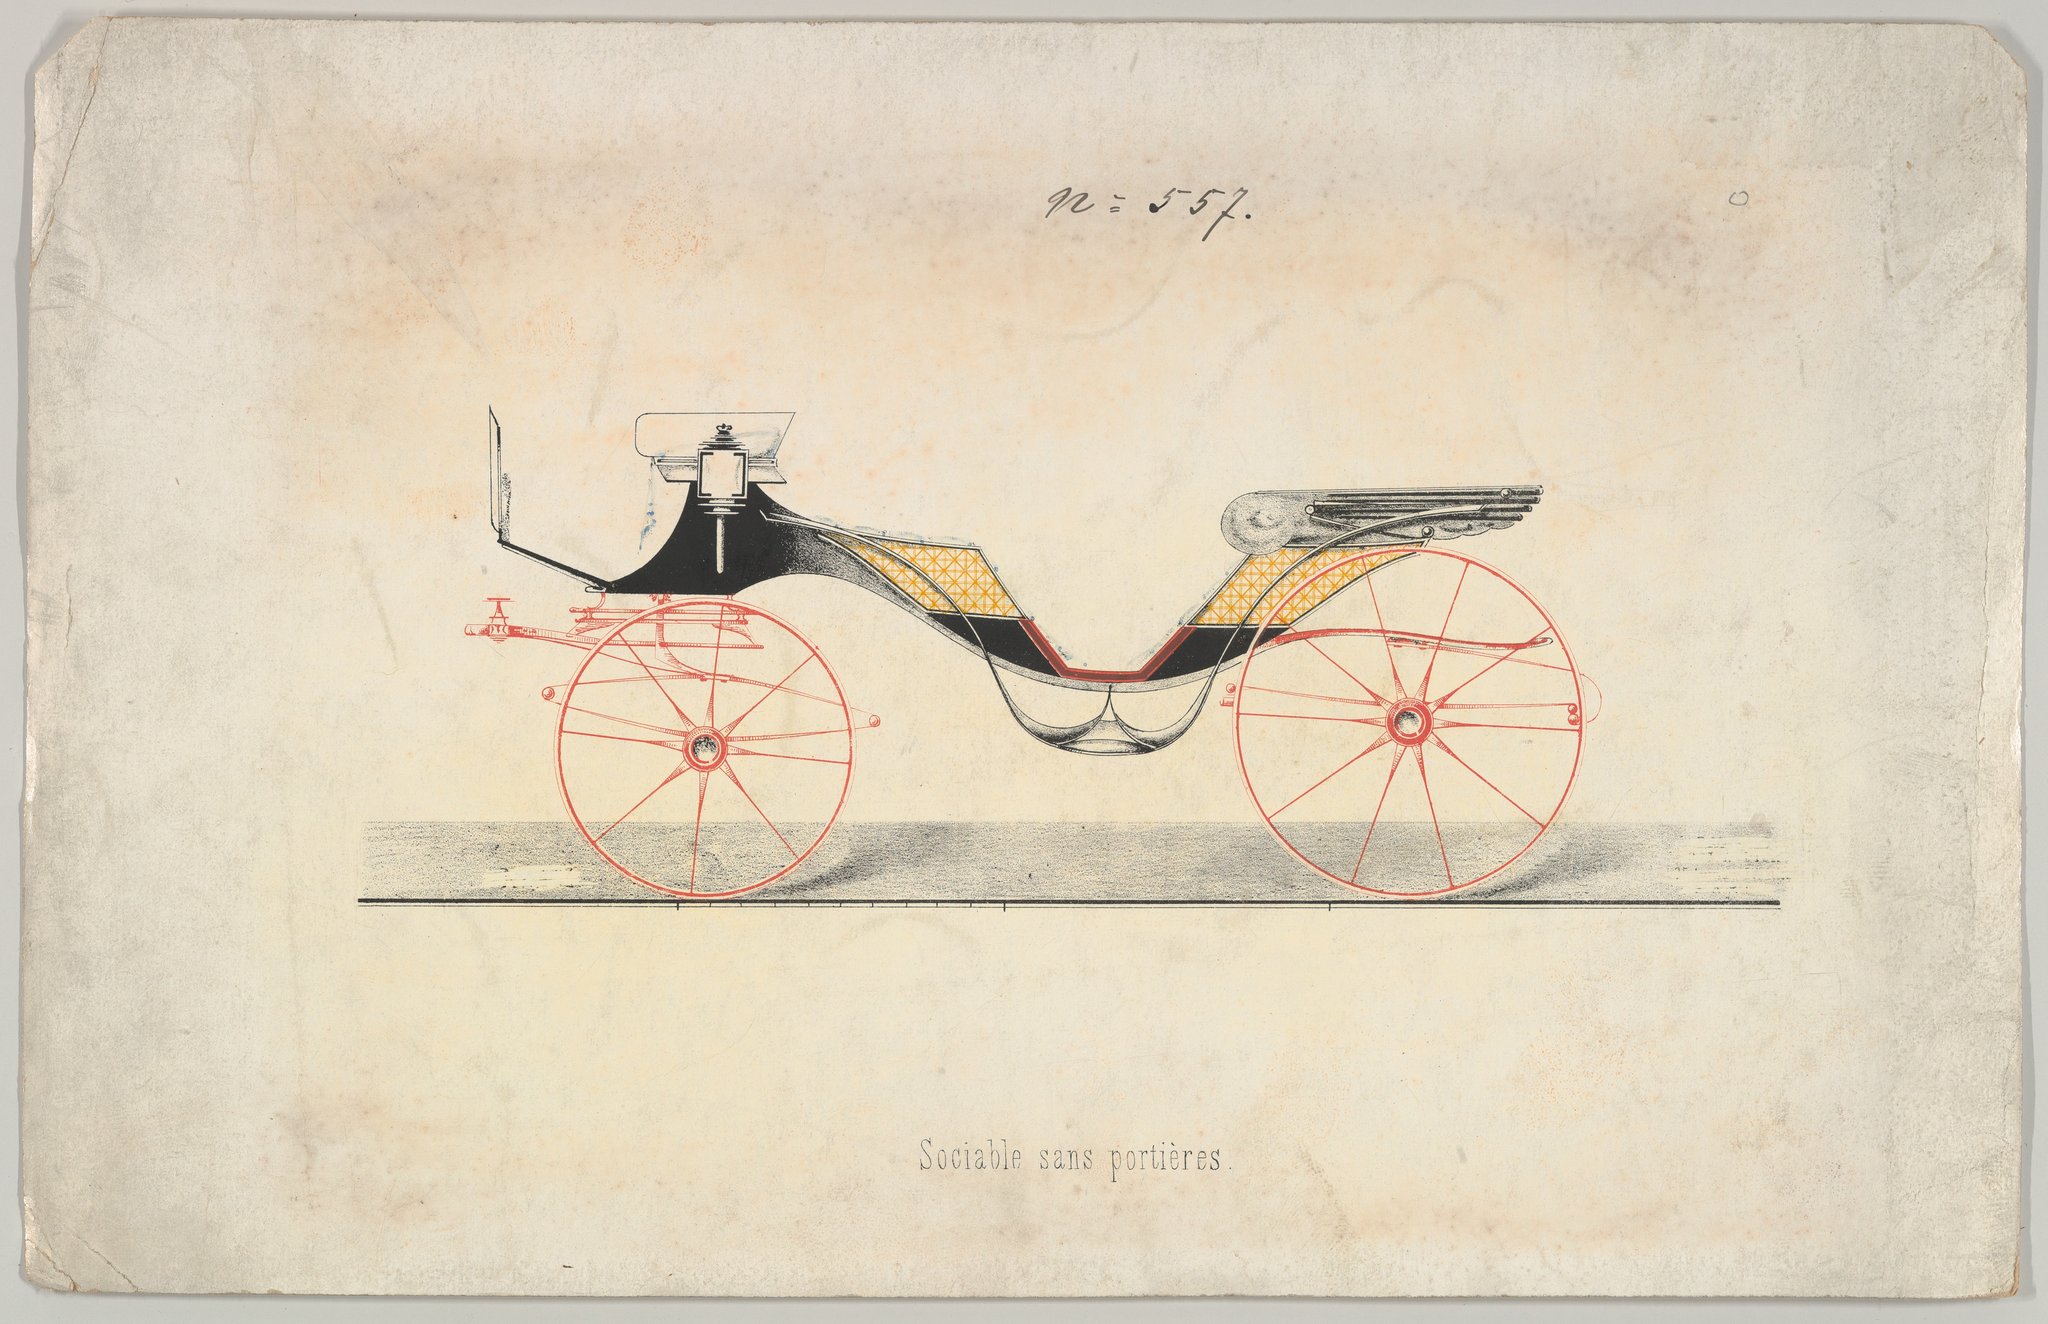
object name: print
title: Sociable #557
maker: anonymous, french, 19th century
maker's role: artist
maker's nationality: french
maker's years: 1800-1900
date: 1870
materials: gum arabic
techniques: lithograph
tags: carriages